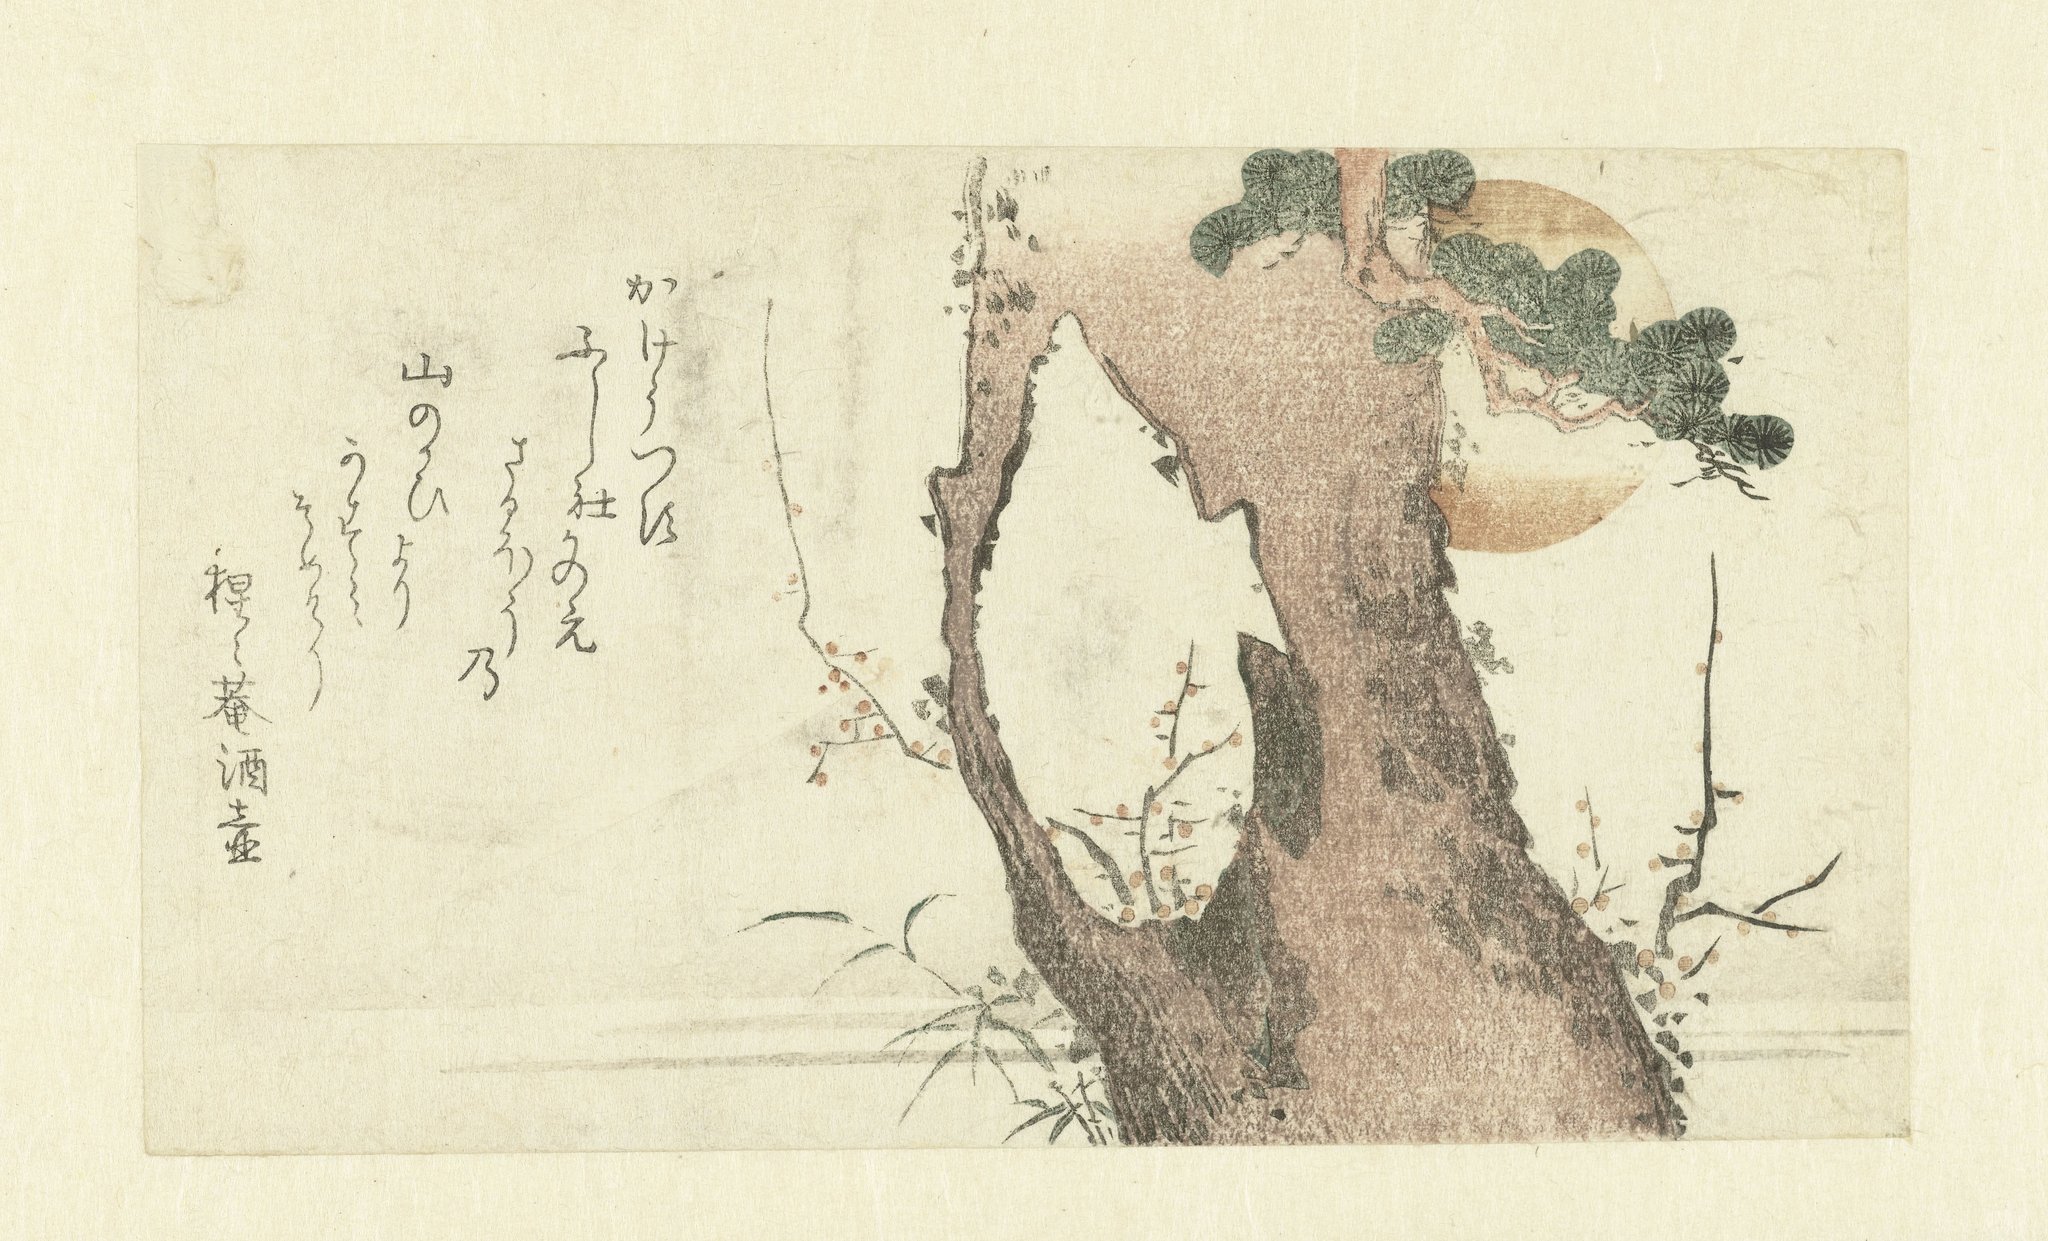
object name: surimono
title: Fuji en een pijnboom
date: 1790-1800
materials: paper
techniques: blind stamped, woodcut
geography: japan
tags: sunrise, trees: pine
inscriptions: collector's mark, verso, stamped: Lugt 2973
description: Een surimono is een luxe uitgevoerde prent waarop beeld met één of meerdere gedichten gecombineerd is. Bij het drukken van een surimono werd vaak gebruik gemaakt van dikker papier, blinddruk en metaal pigmenten, zoals koper- en zilverpoeder. De prenten werden vaak in opdracht van dichters gemaakt en als exclusief geschenk aan vrienden en relaties gegeven.